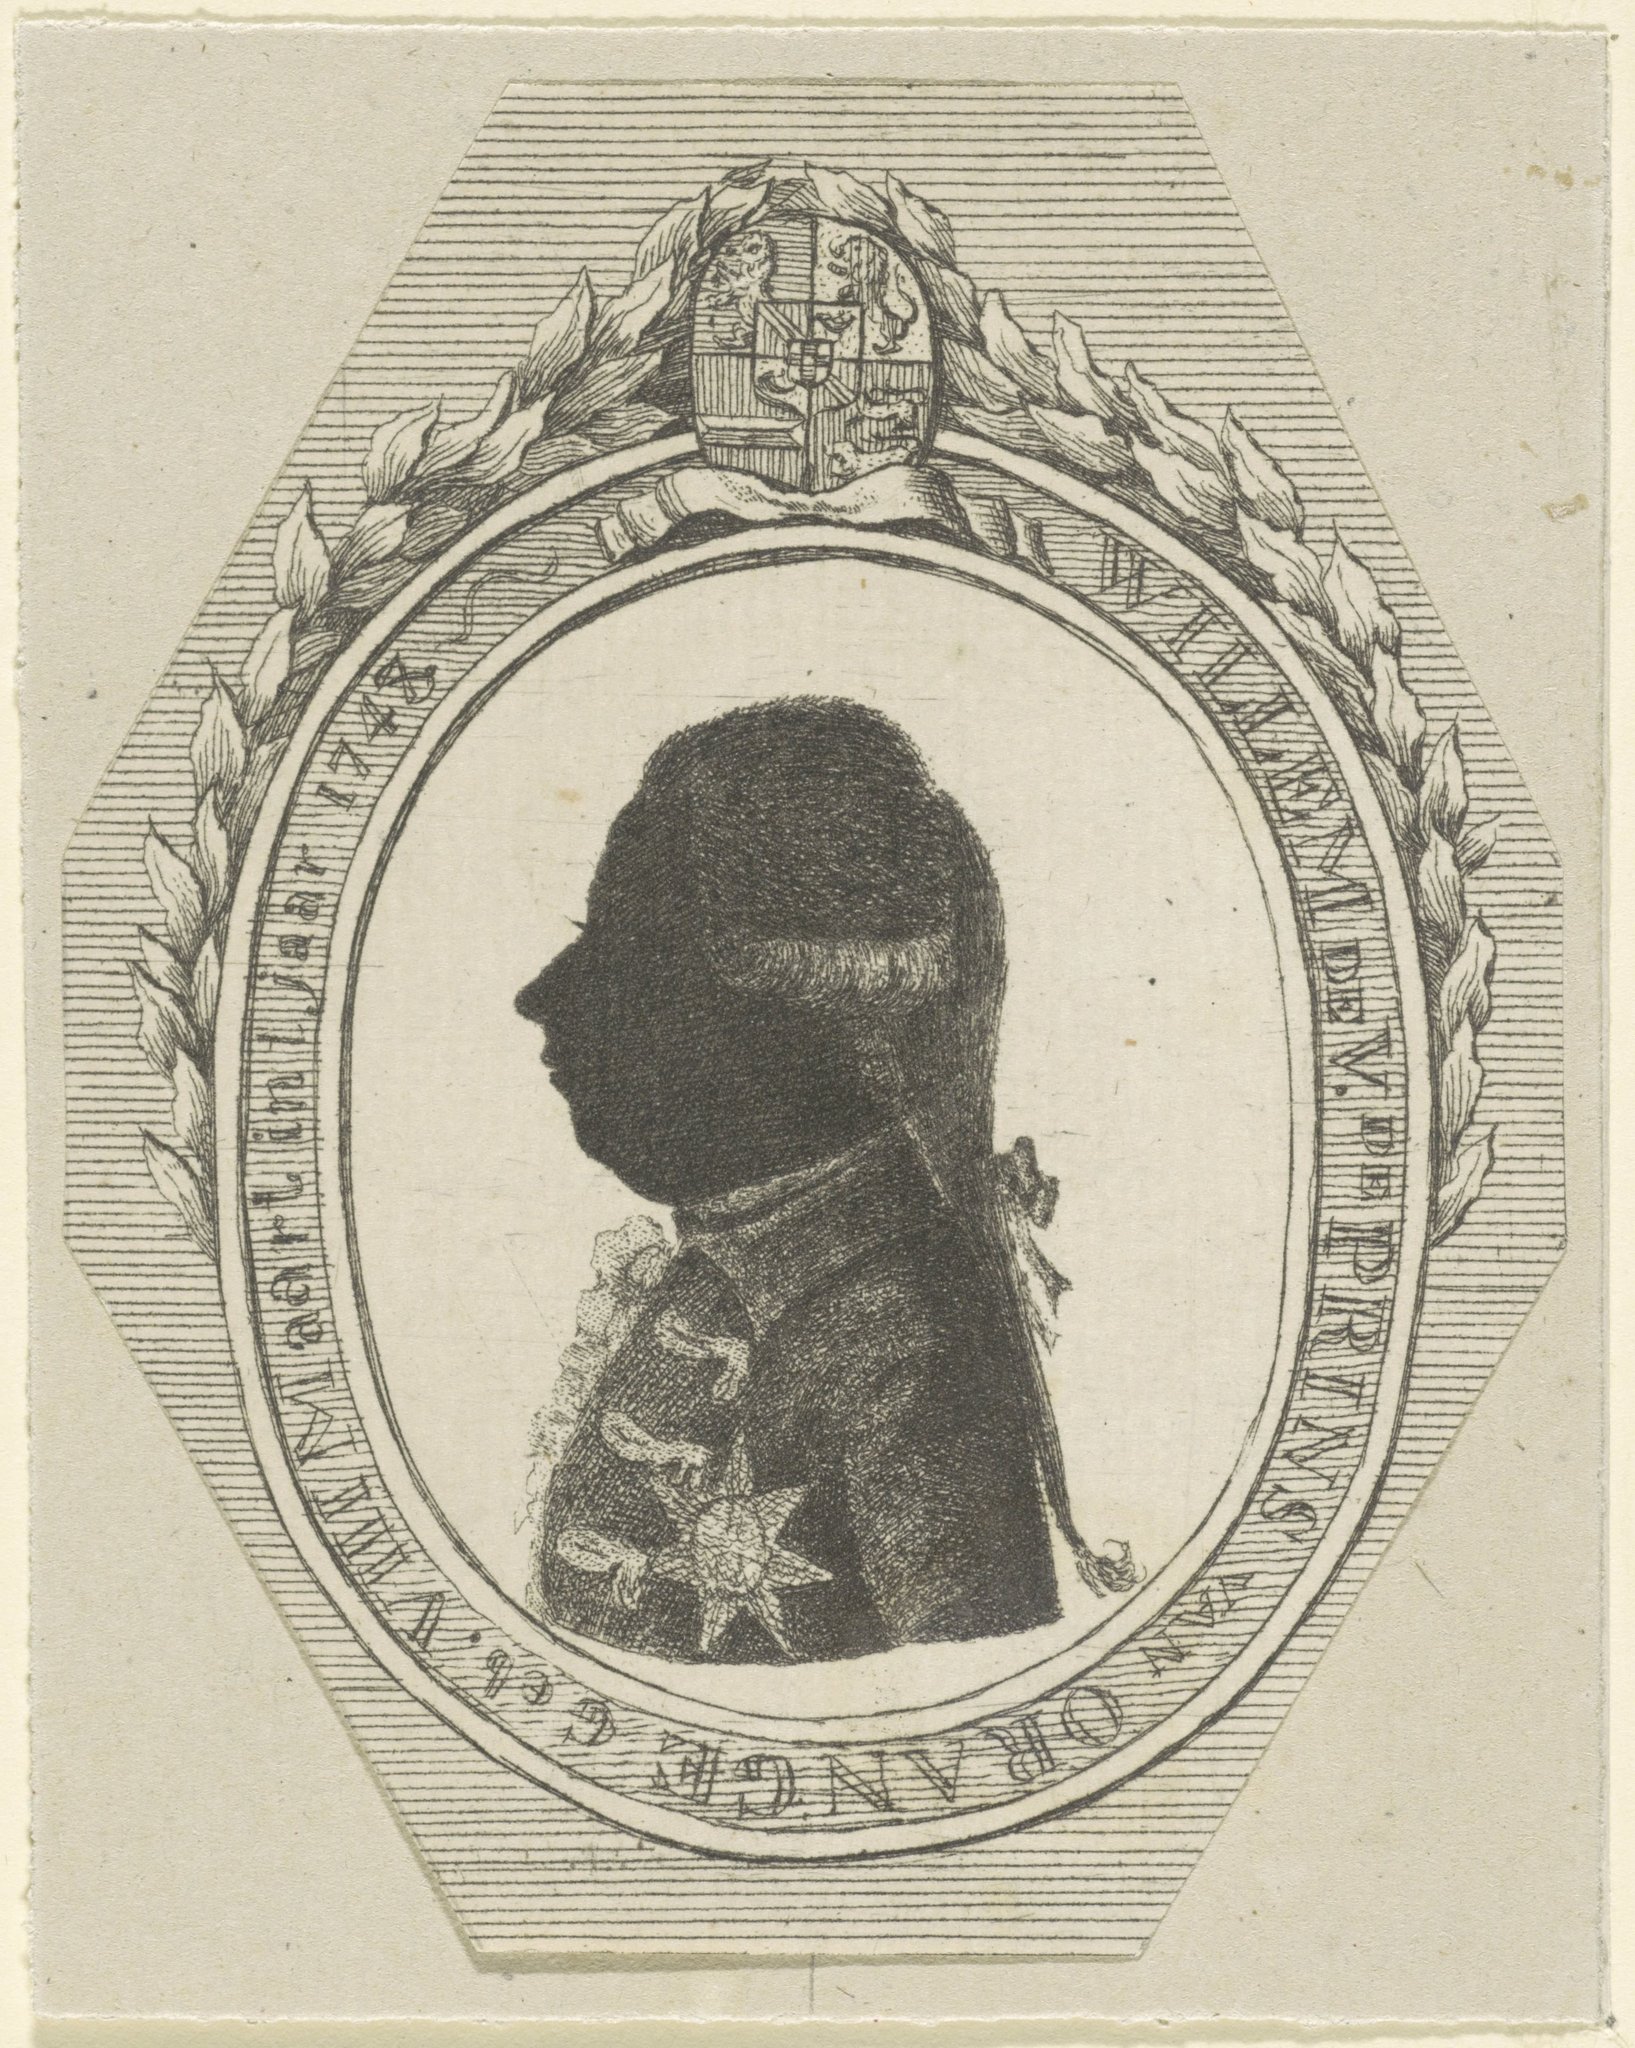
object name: print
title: Silhouetportret van Willem V, prins van Oranje-Nassau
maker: Anonymous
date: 1775-1849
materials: paper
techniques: etching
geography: low countries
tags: the hague, william v (prince of orange)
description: De hier vermelde titel verwijst naar de hoogst verkregen titel van de geportretteerde, niet per se naar de titel die de geportretteerde op deze voorstelling draagt.